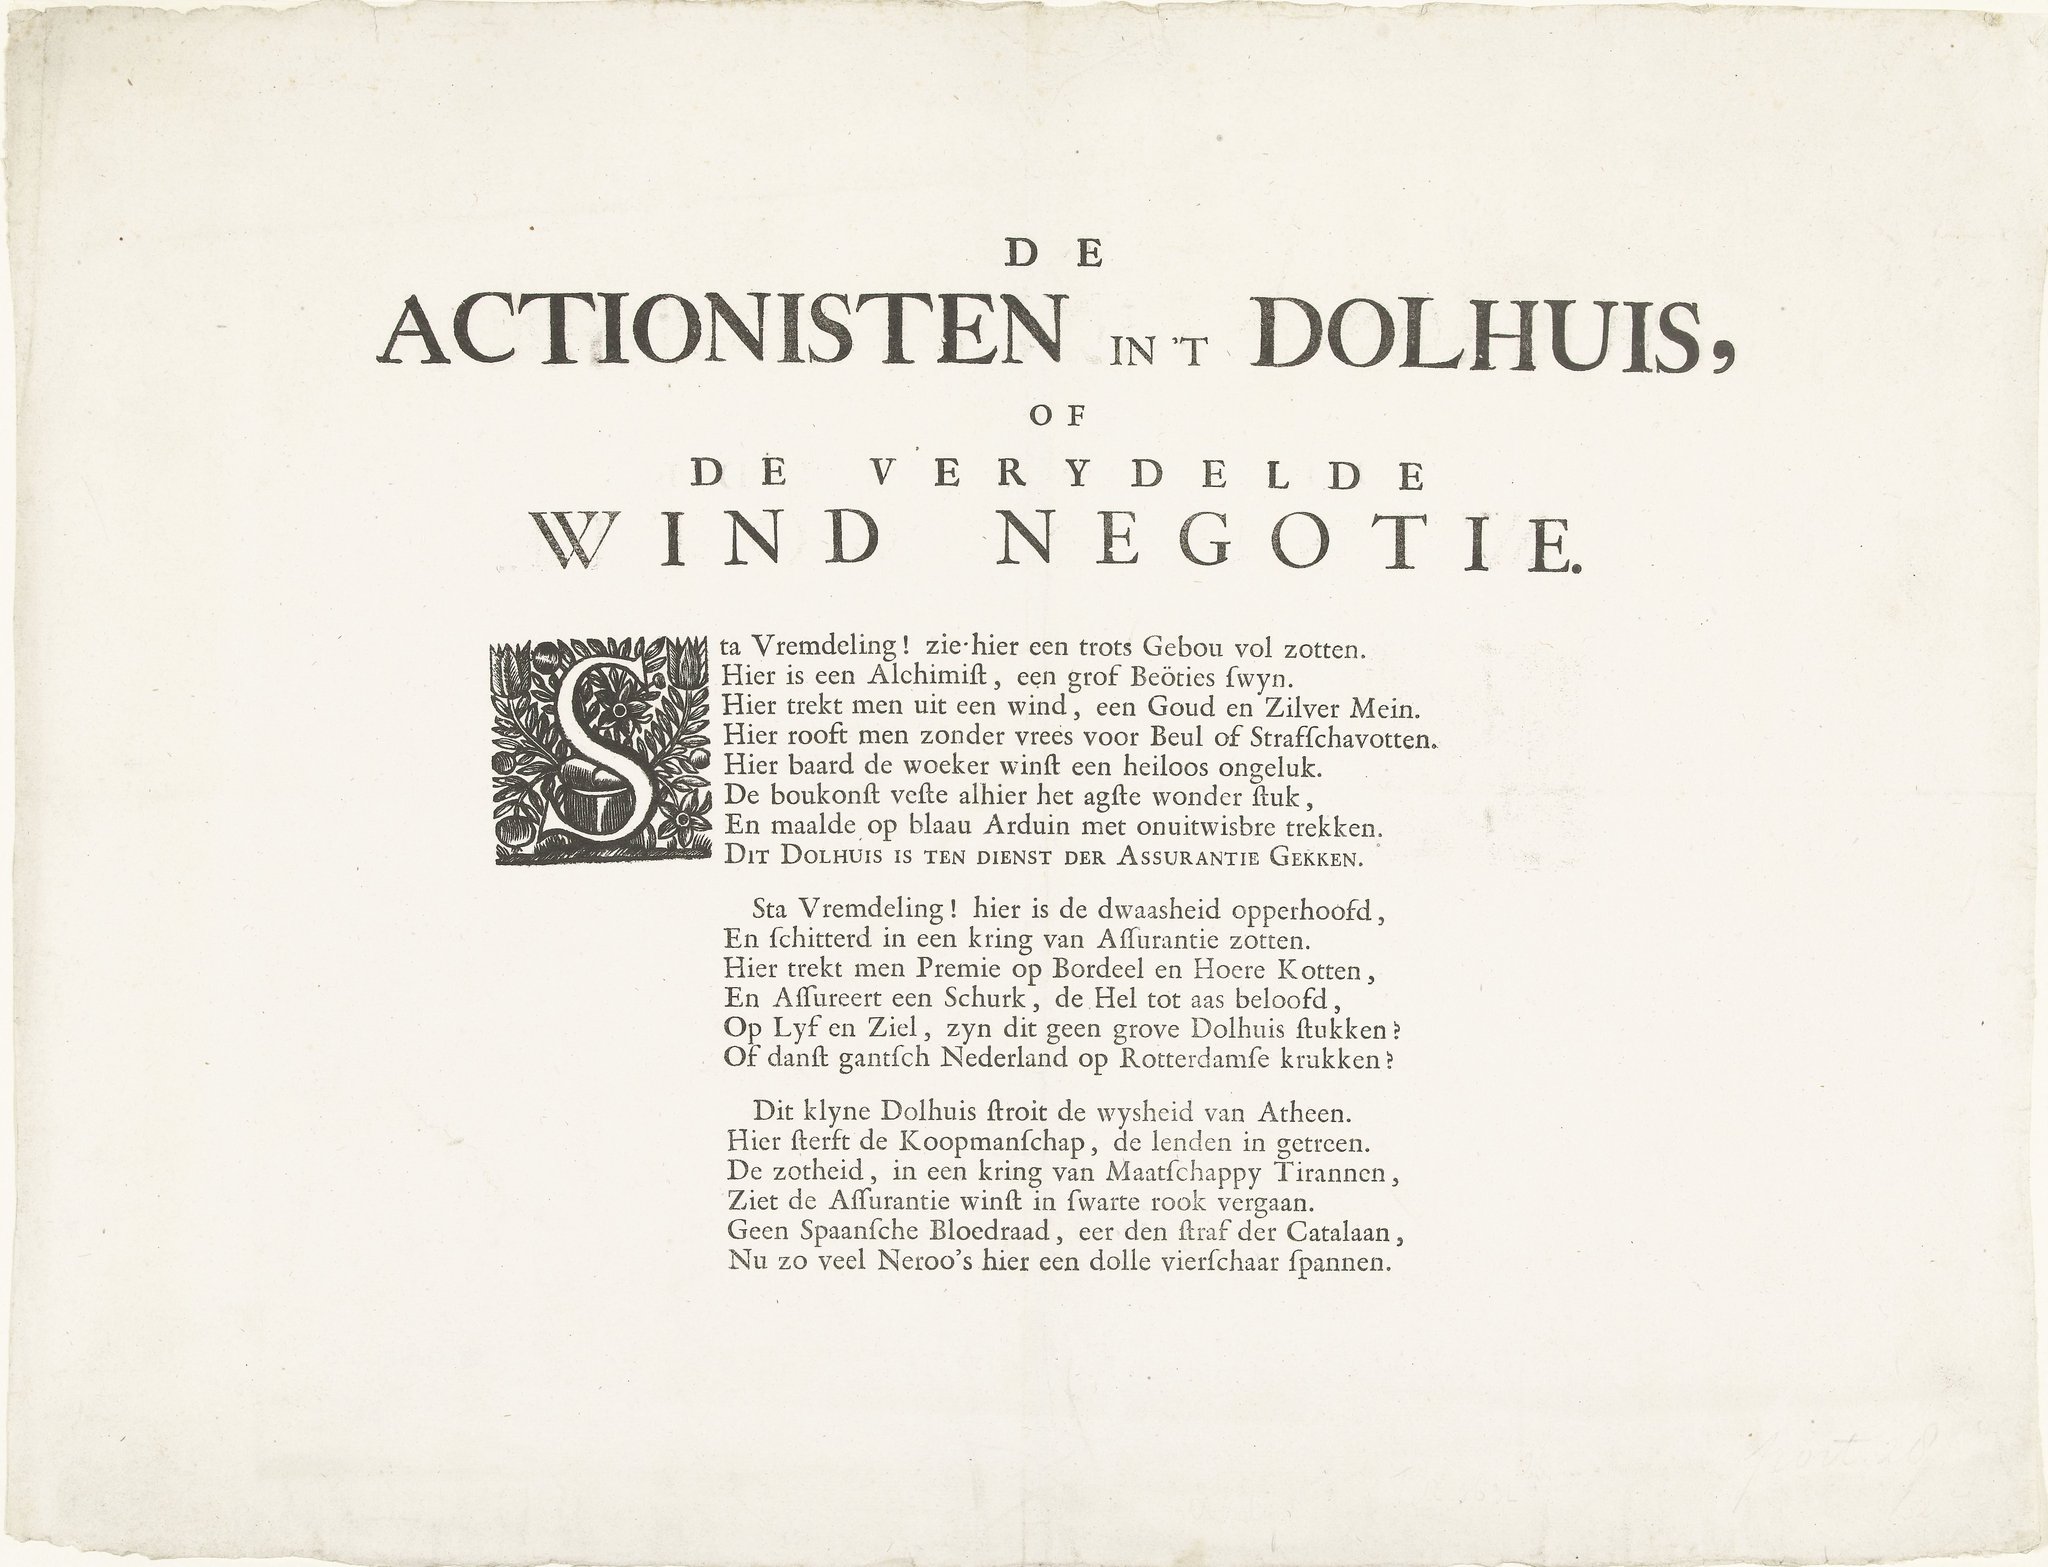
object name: print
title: Het Groote Tafereel der Dwaasheid (extra stukken)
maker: Anonymous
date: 1720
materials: paper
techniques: letterpress printing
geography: northern netherlands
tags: beurs van hendrik de keyser, windhandel van 1720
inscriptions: collector's mark: Lugt 2228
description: Blad met een vers in drie coupletten waarin de spot wordt gedreven met de actionisten en de windhandel in het jaar 1720. Met versierde initiaal S. Behoort tot de groep van bijprenten toegevoegd aan de serie Tafereel der Dwaasheid met spotprenten op de Windhandel of Actiehandel van 1720.